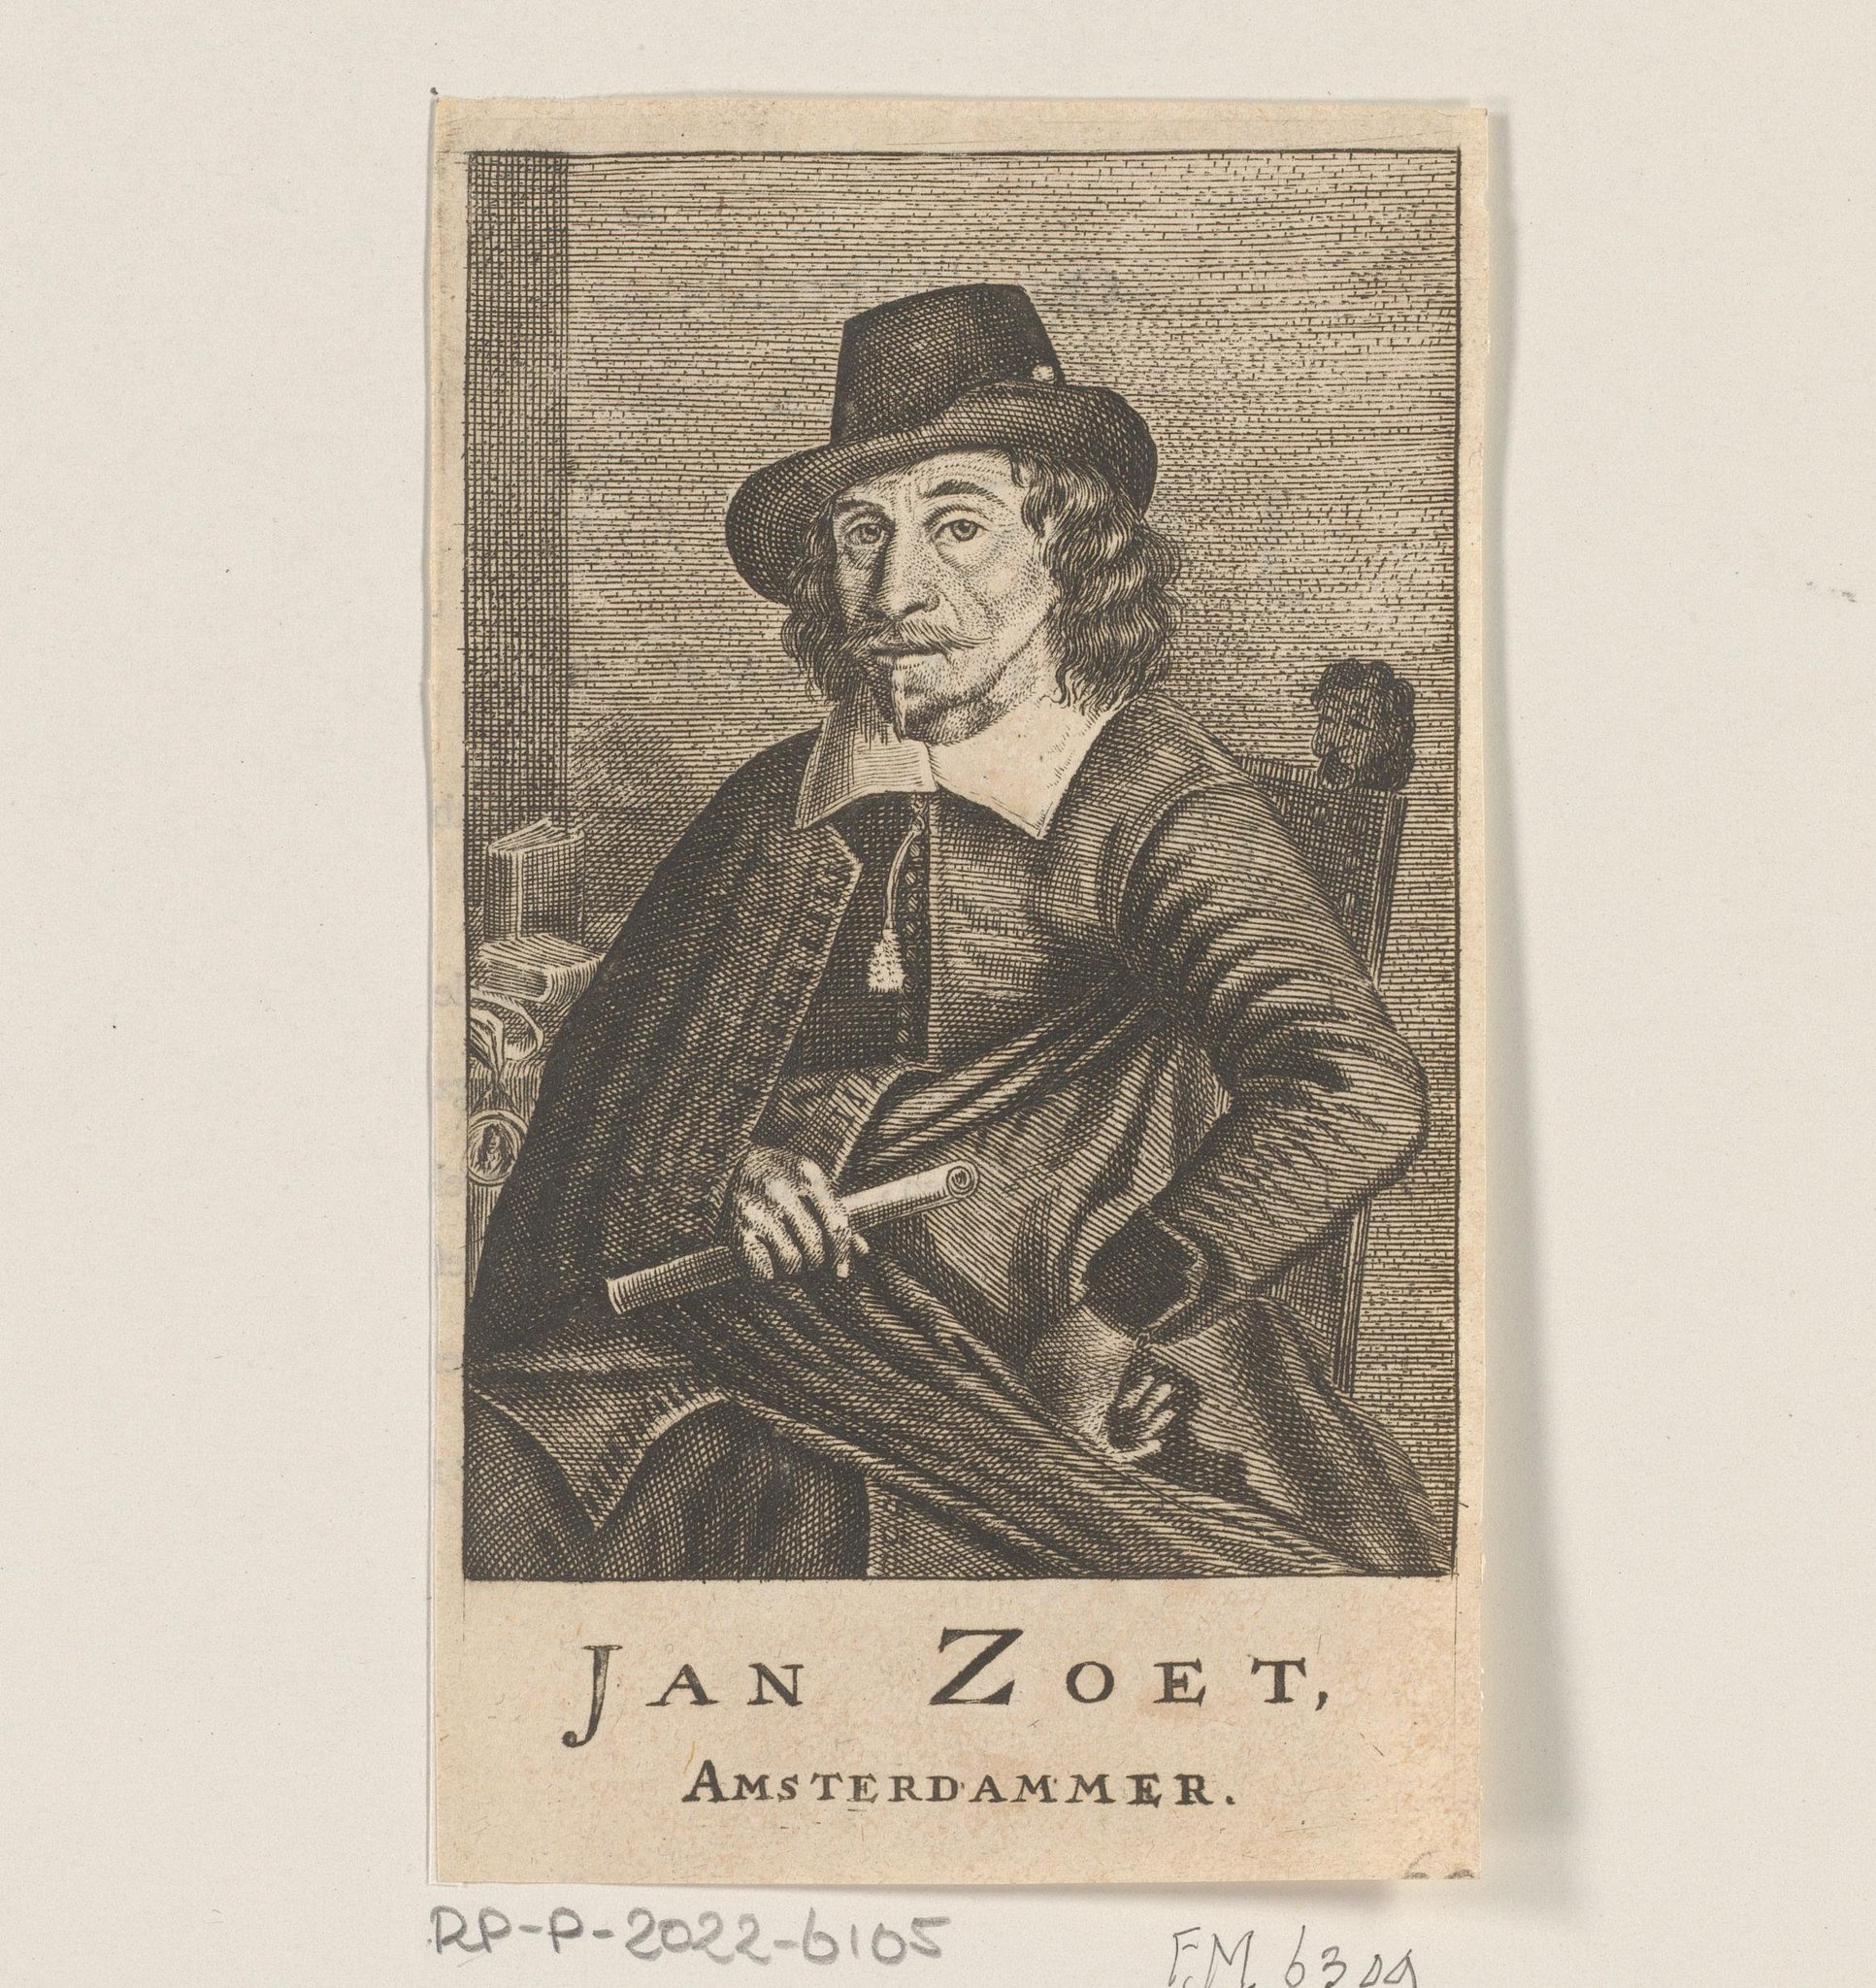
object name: print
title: Portret van Jan Zoet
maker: Anonymous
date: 1649-1750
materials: paper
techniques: engraving, letterpress printing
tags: amsterdam, jan zoet, historical persons, writer, poet, author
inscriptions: inscription: ‘Op d'Afbeelding / (...) M. J. Franse[...]’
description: Met tweeregelig onderschrift in het Nederlands.